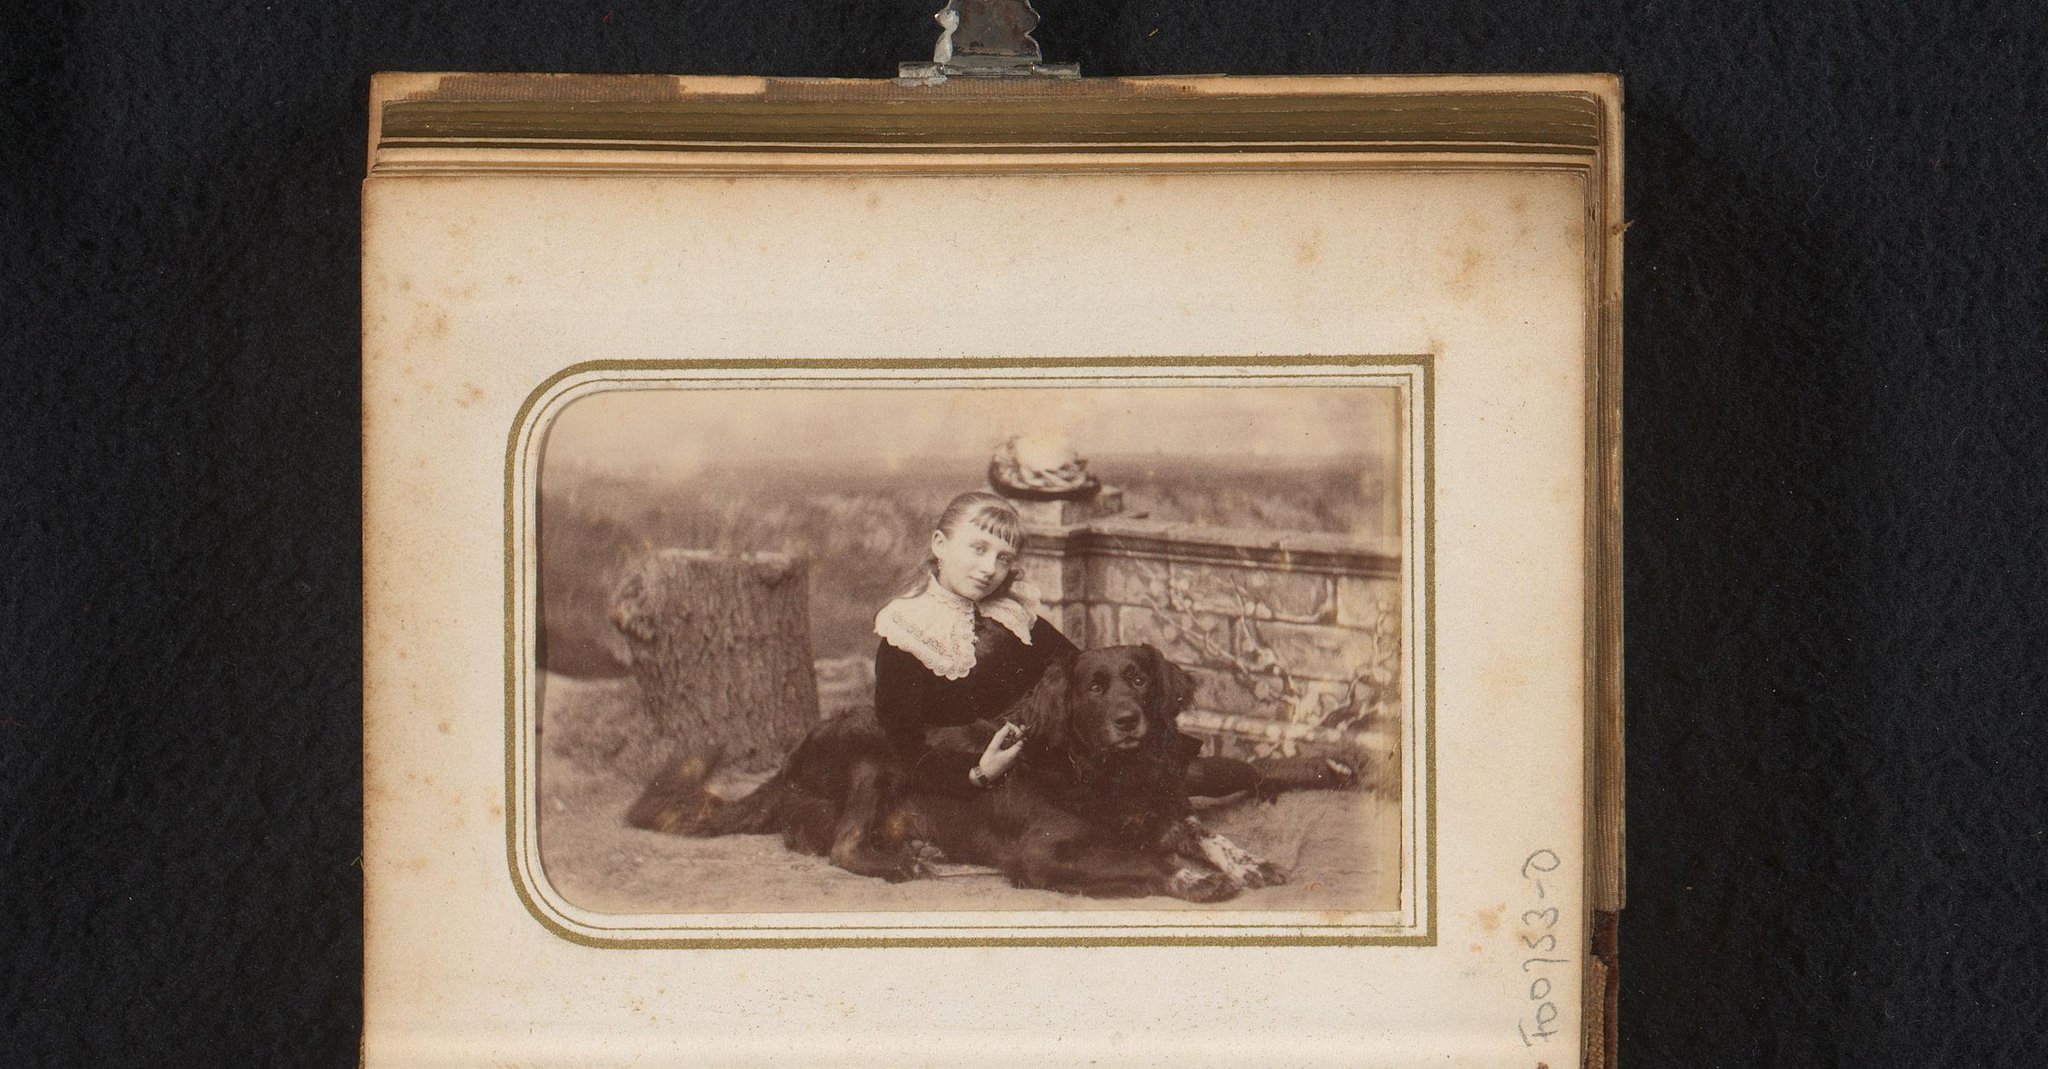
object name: album leaf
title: Portret van een zittend meisje bij een hond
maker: hendrik jan van dorp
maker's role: fotograaf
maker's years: 1844-1928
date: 1880-1908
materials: cardboard, photographic support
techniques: albumen print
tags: historical persons, girl (child between toddler and youth), dog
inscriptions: inscription: ‘Photographie/ H.J. van Dorp/ Rotterdam/ Kipstraat No. 101/ tegenover 't Stadhuis (...)’